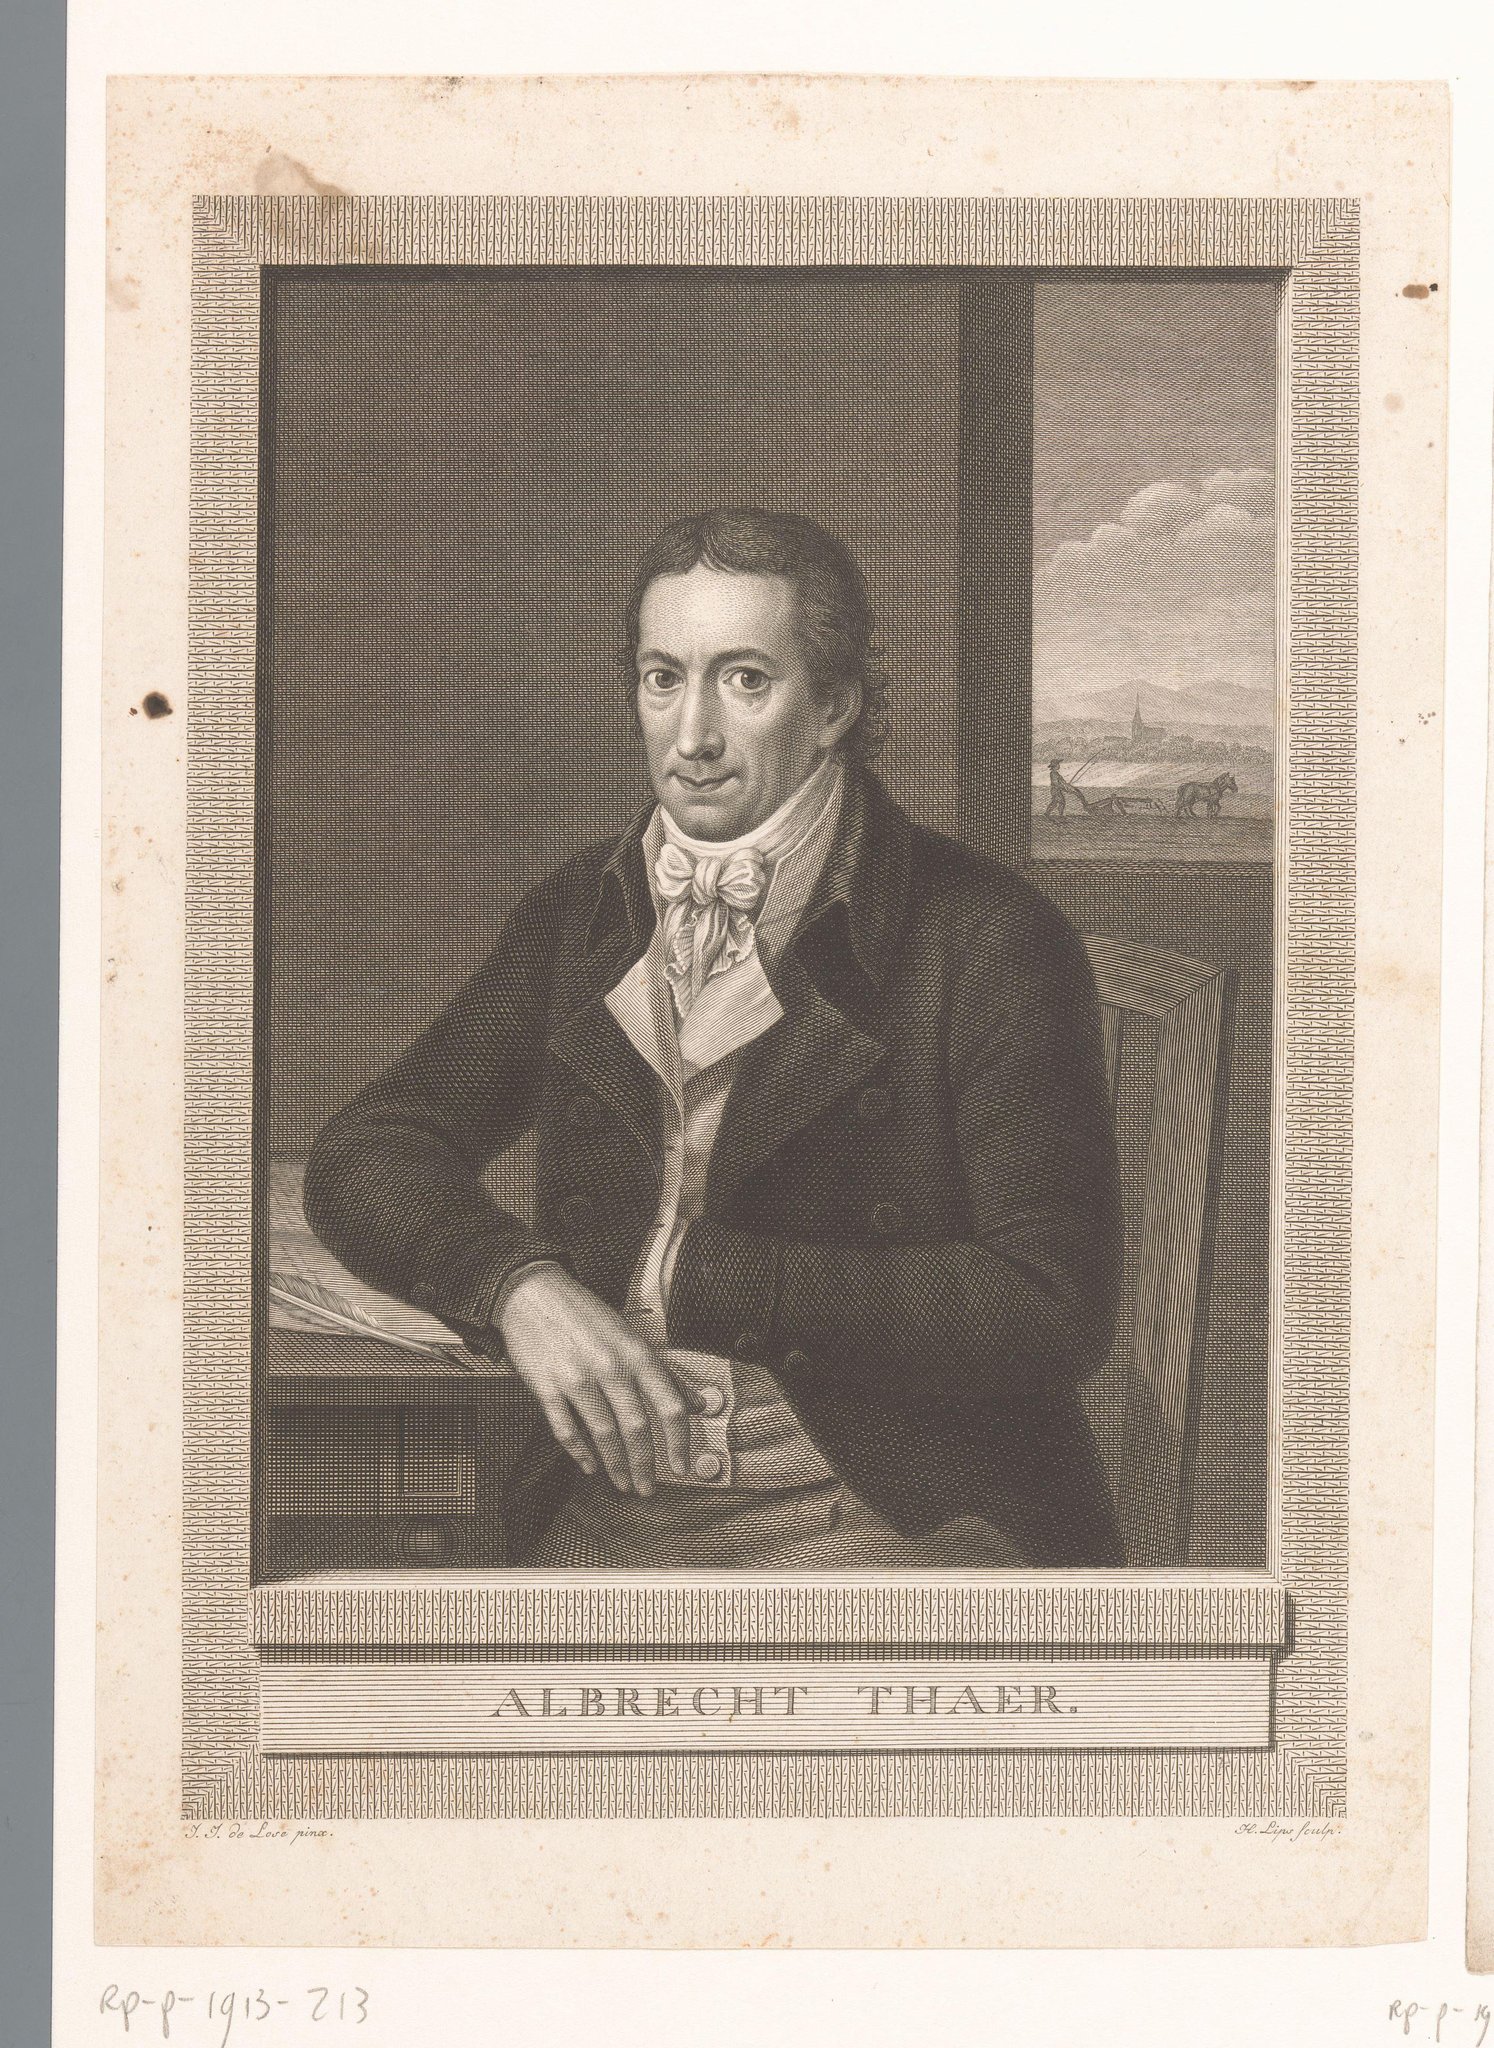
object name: print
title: Portret van Albrecht Daniel Thaer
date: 1768-1817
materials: paper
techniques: engraving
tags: albrecht daniel thaer, quill, historical persons, ploughing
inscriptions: collector's mark: Lugt 2228